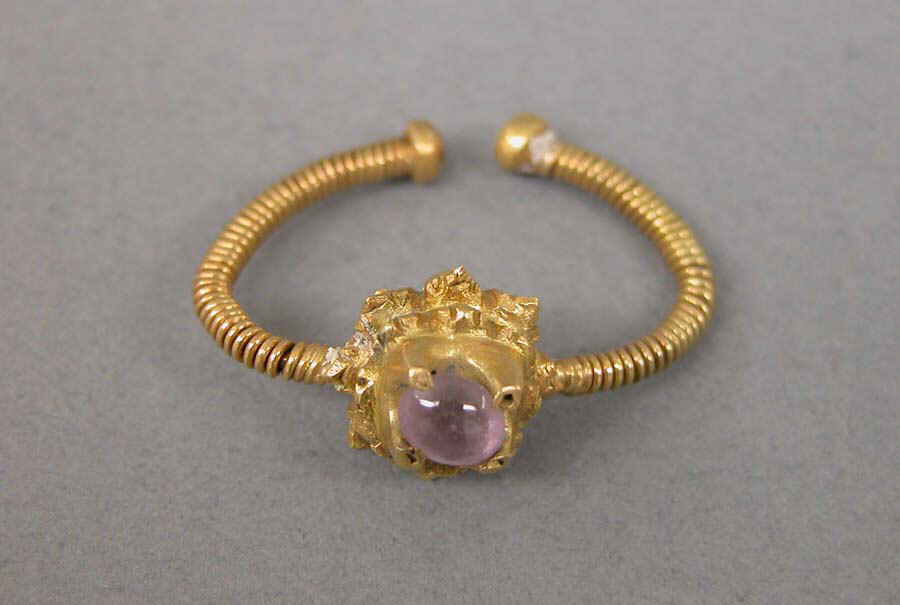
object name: ring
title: Ring with Purple Stone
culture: indonesian, javanese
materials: gold, stone